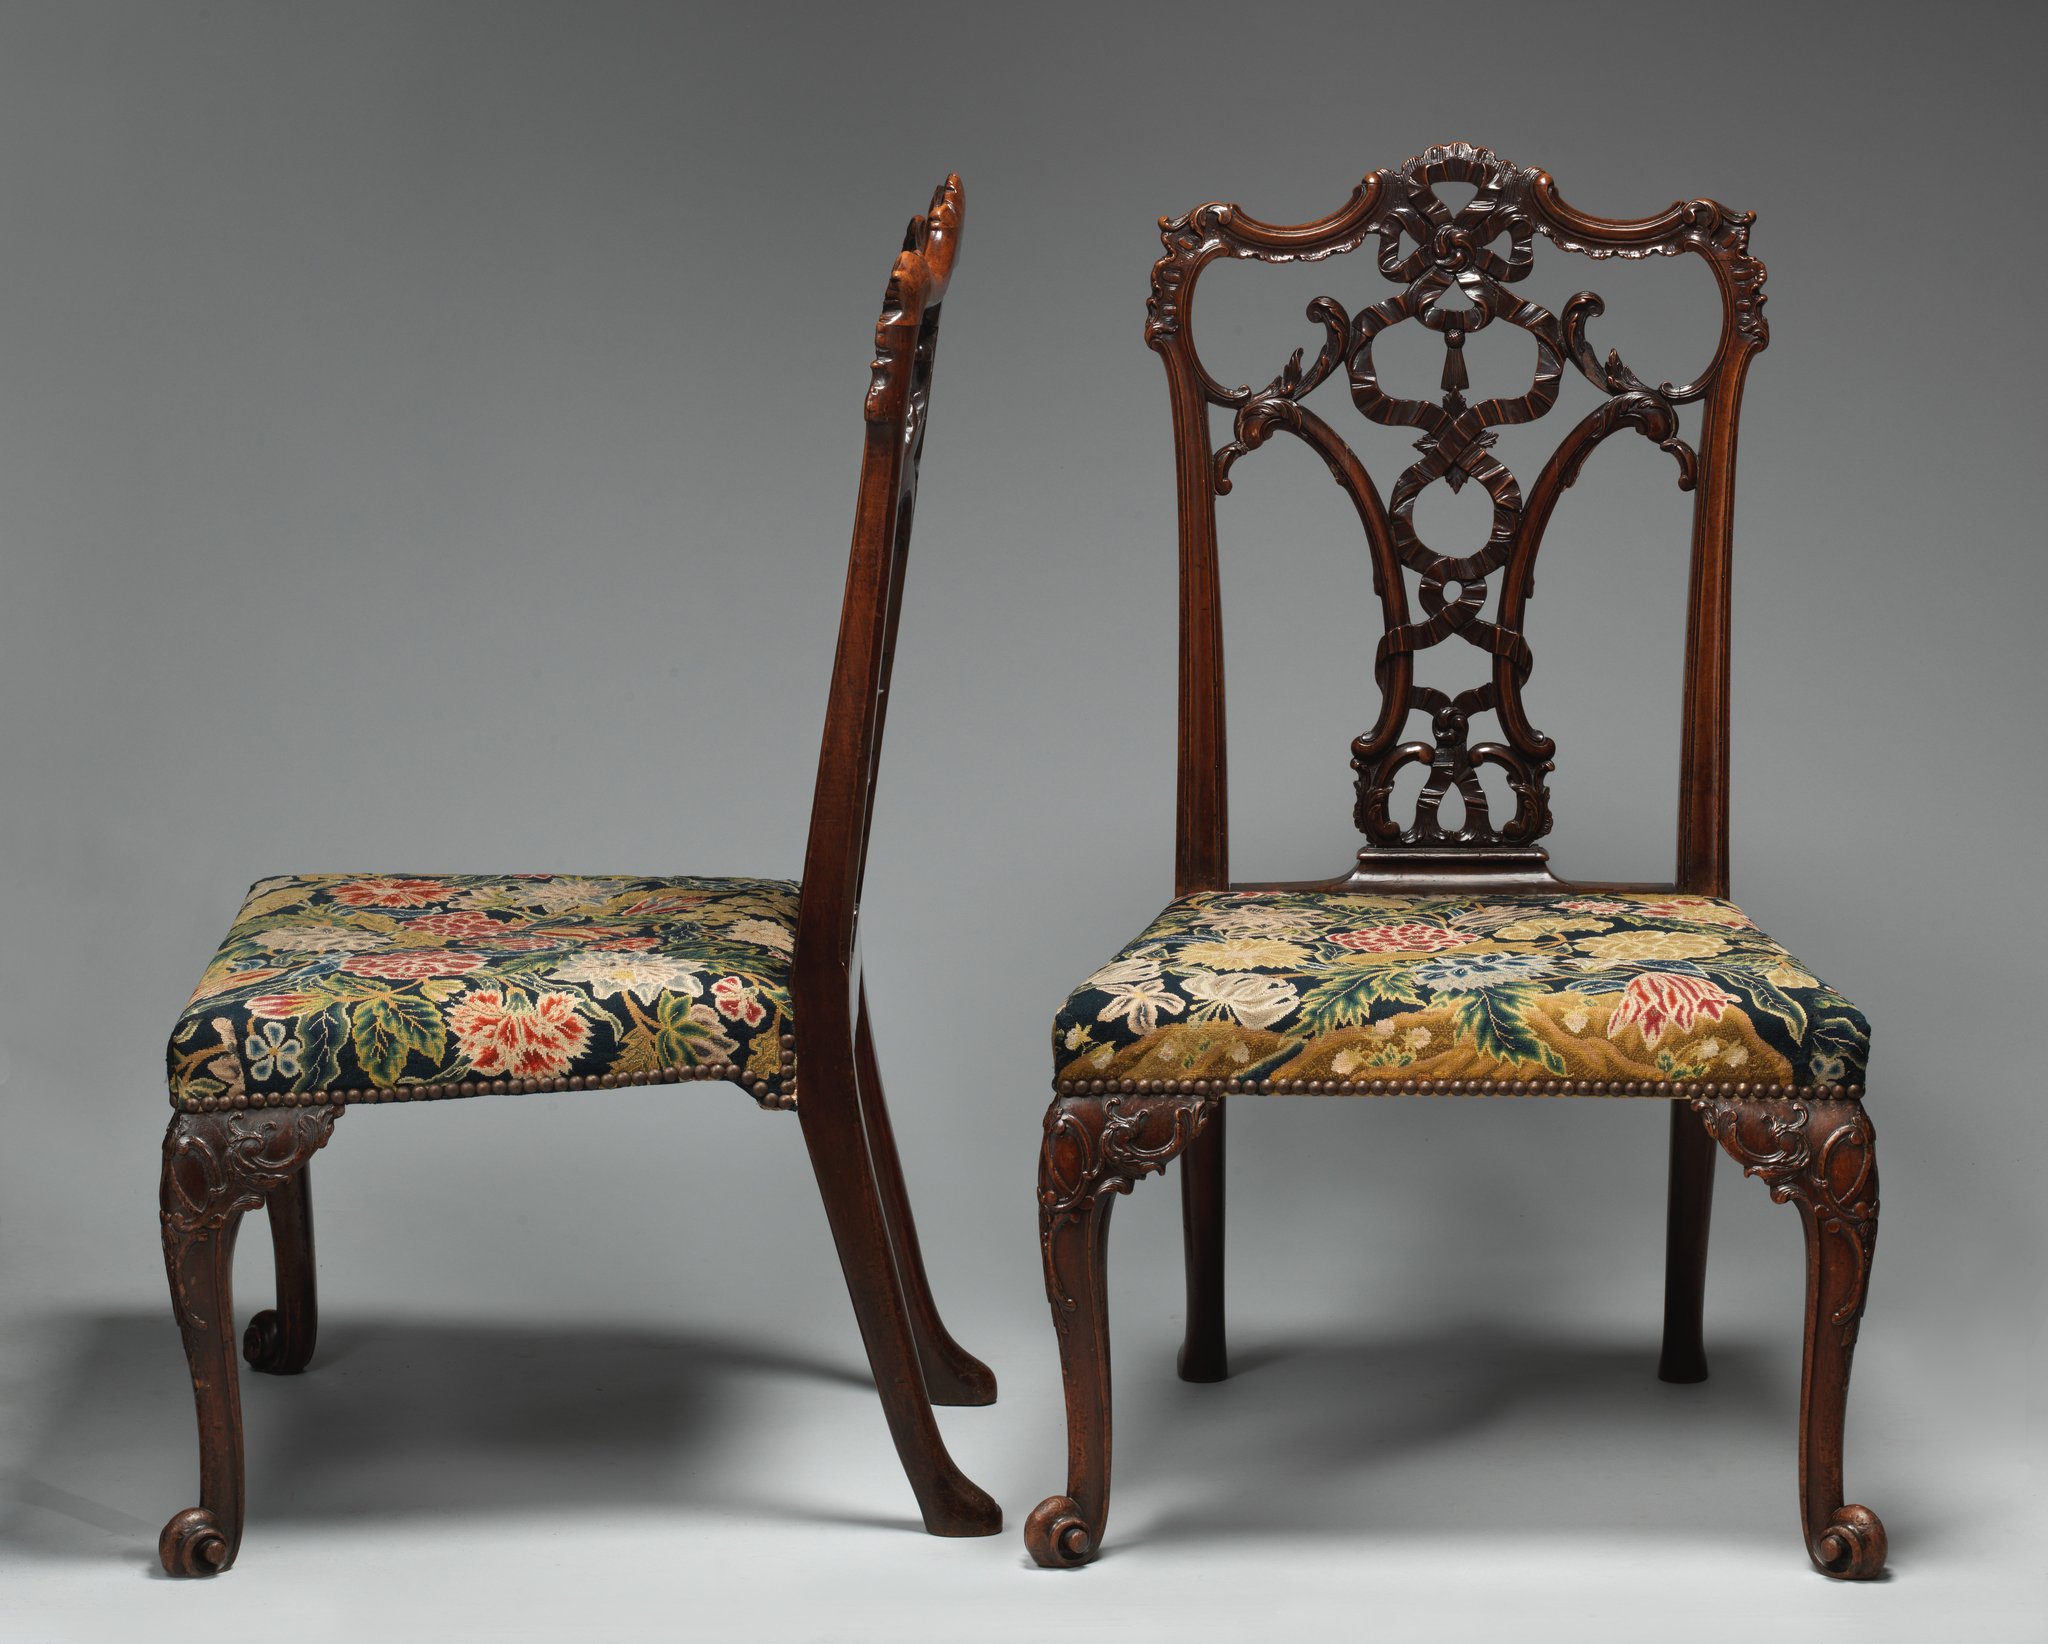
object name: side chair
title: Side chair (one of a pair)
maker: thomas chippendale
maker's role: designer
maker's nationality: british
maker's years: 1718-1779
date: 1755-1760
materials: canvas, wood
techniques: embroidery, stitching